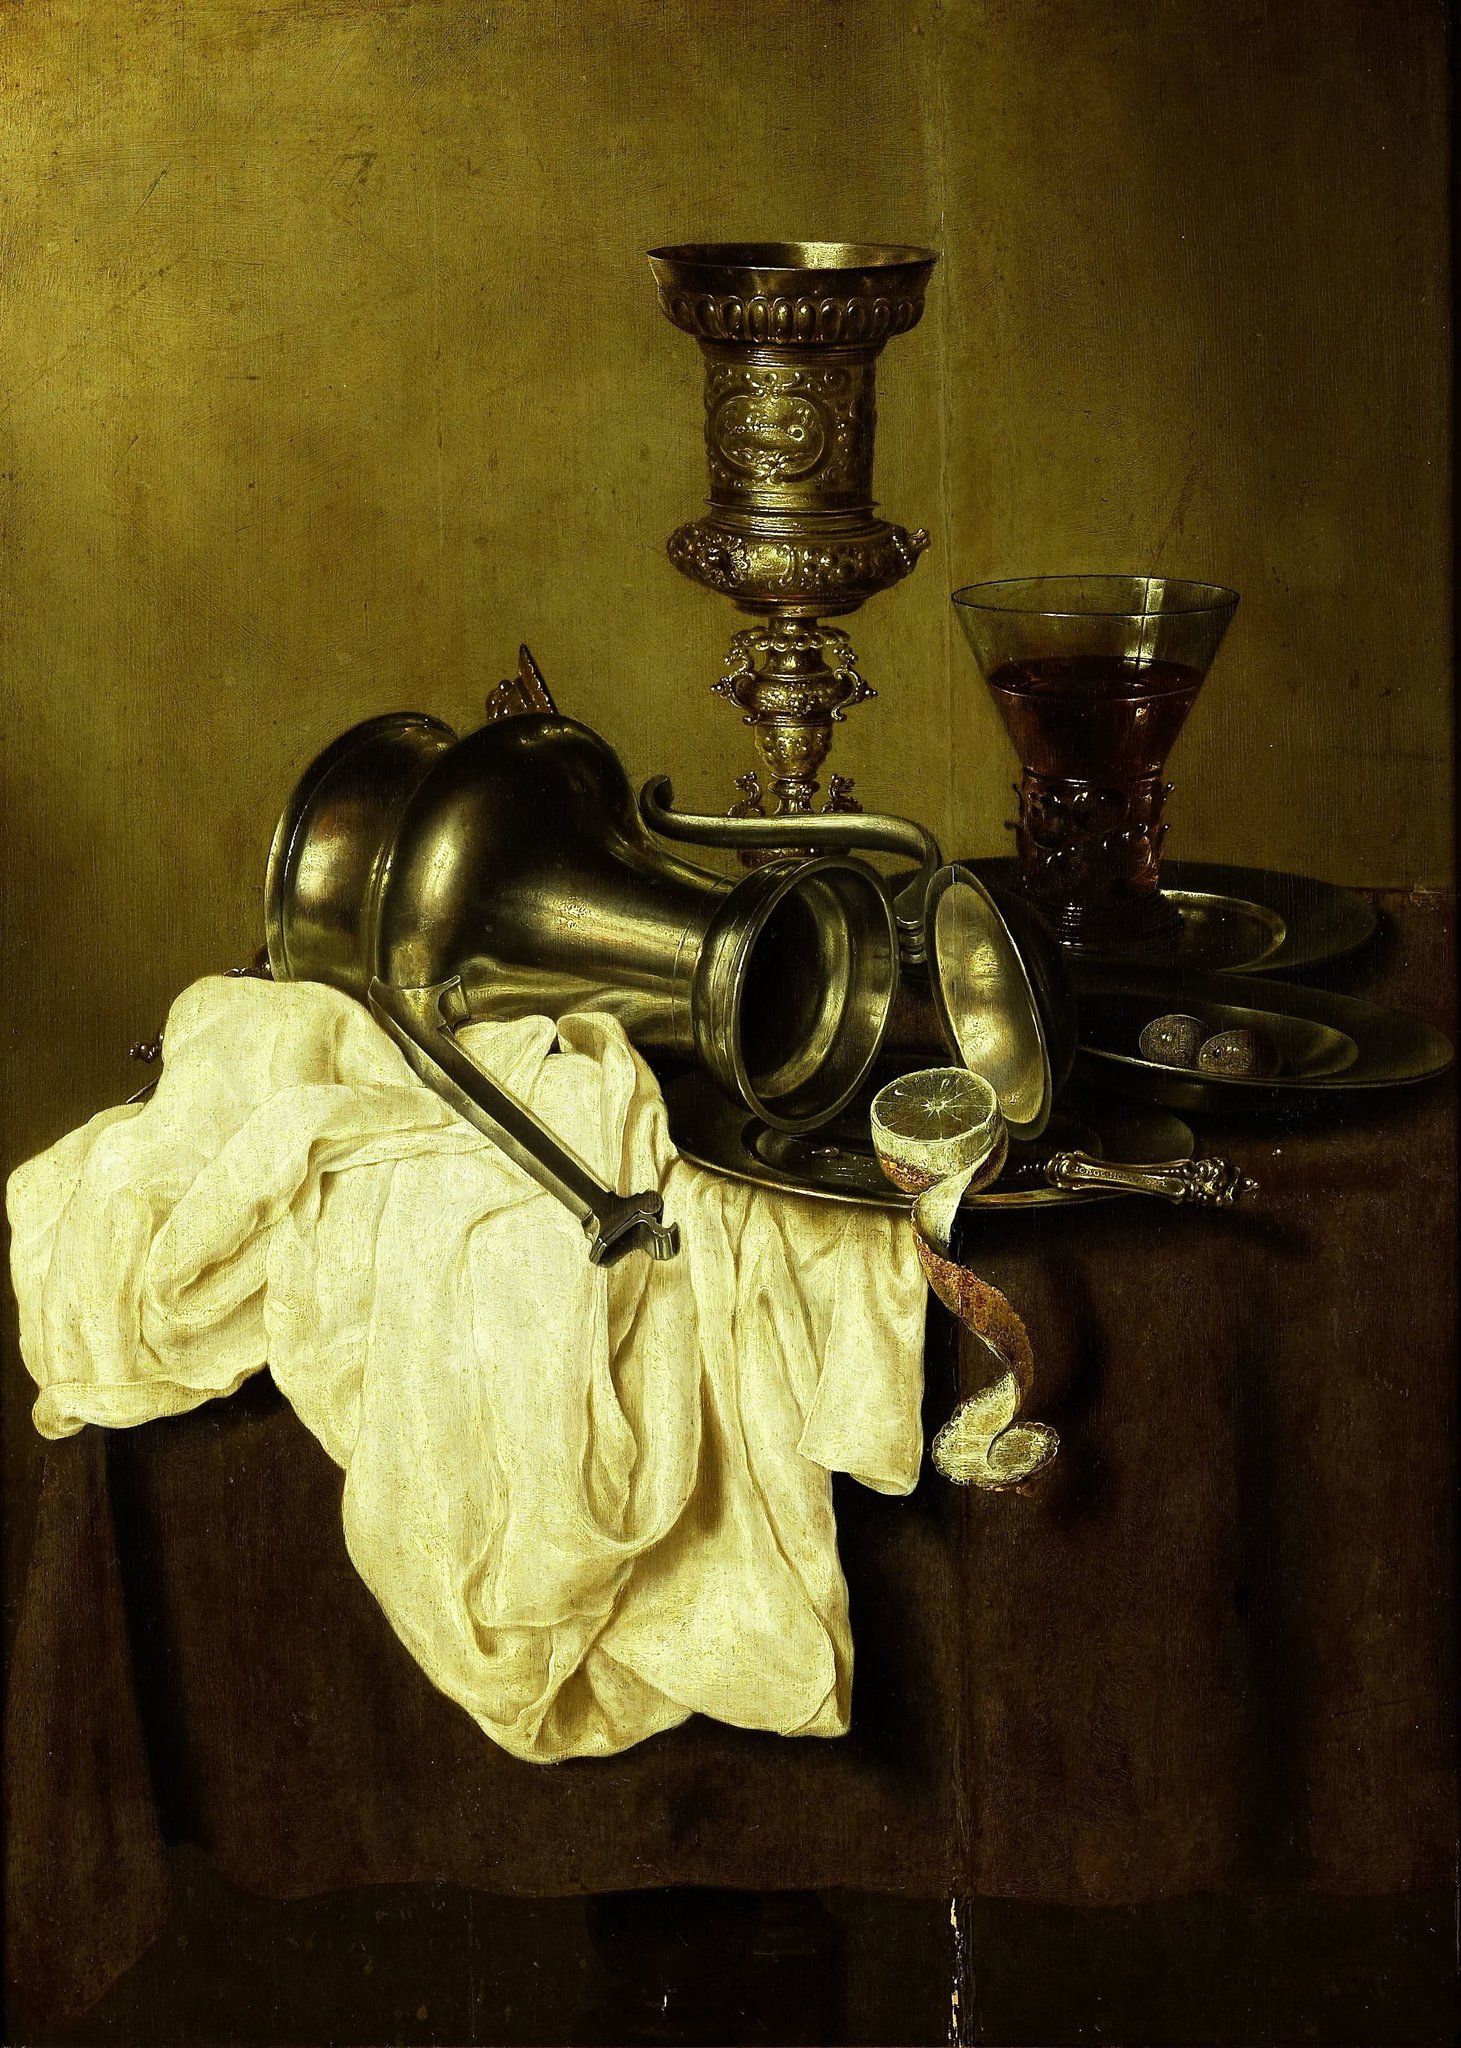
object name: painting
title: Still Life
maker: gerret willemsz. heda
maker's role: painter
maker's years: 1622-1649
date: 1642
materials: oil, panel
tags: containers, still life of related objects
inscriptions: signature and date: ‘Jonge Heda 1642’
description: Stilleven op de hoek van een tafel: tinnen schenkkan en borden met een geschilde citroen, mes en olijven, een berkenmeier met wijn en een zilveren pronkbeker.